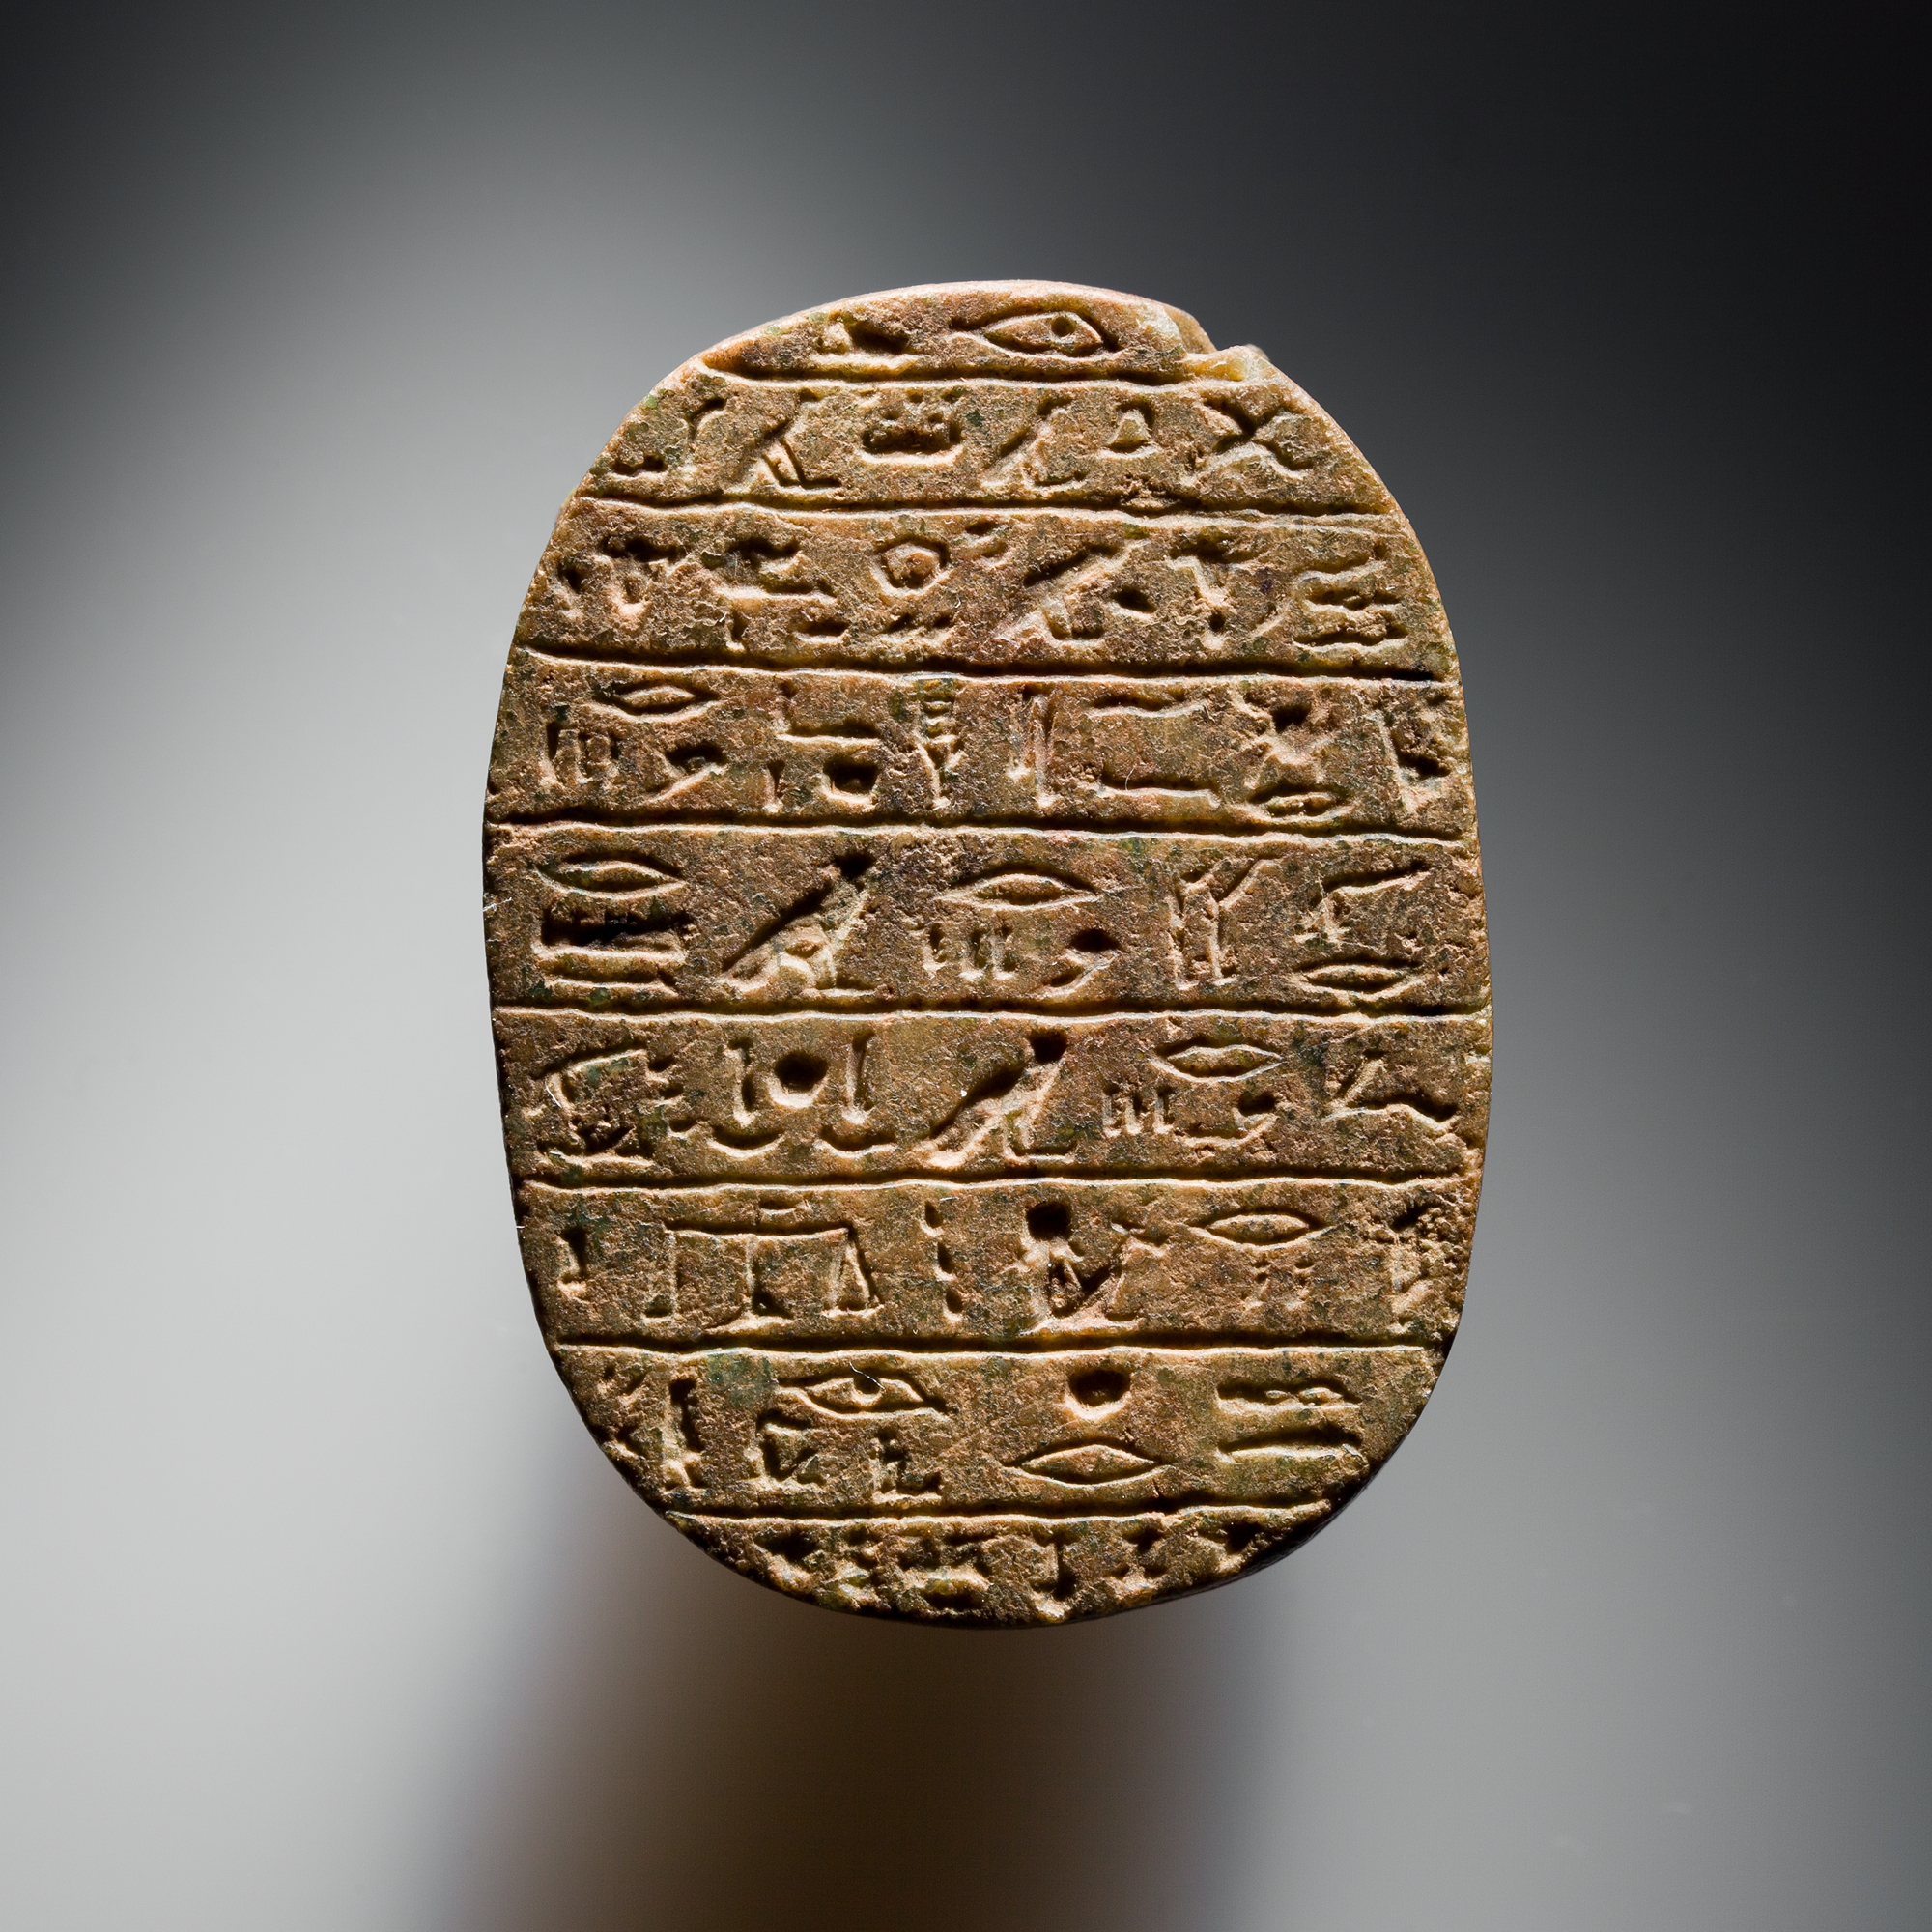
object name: heart scarab, pakasha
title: Heart Scarab of Pakasha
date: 1295-1070 BCE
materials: stone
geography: egypt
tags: hieroglyphs,scarabs